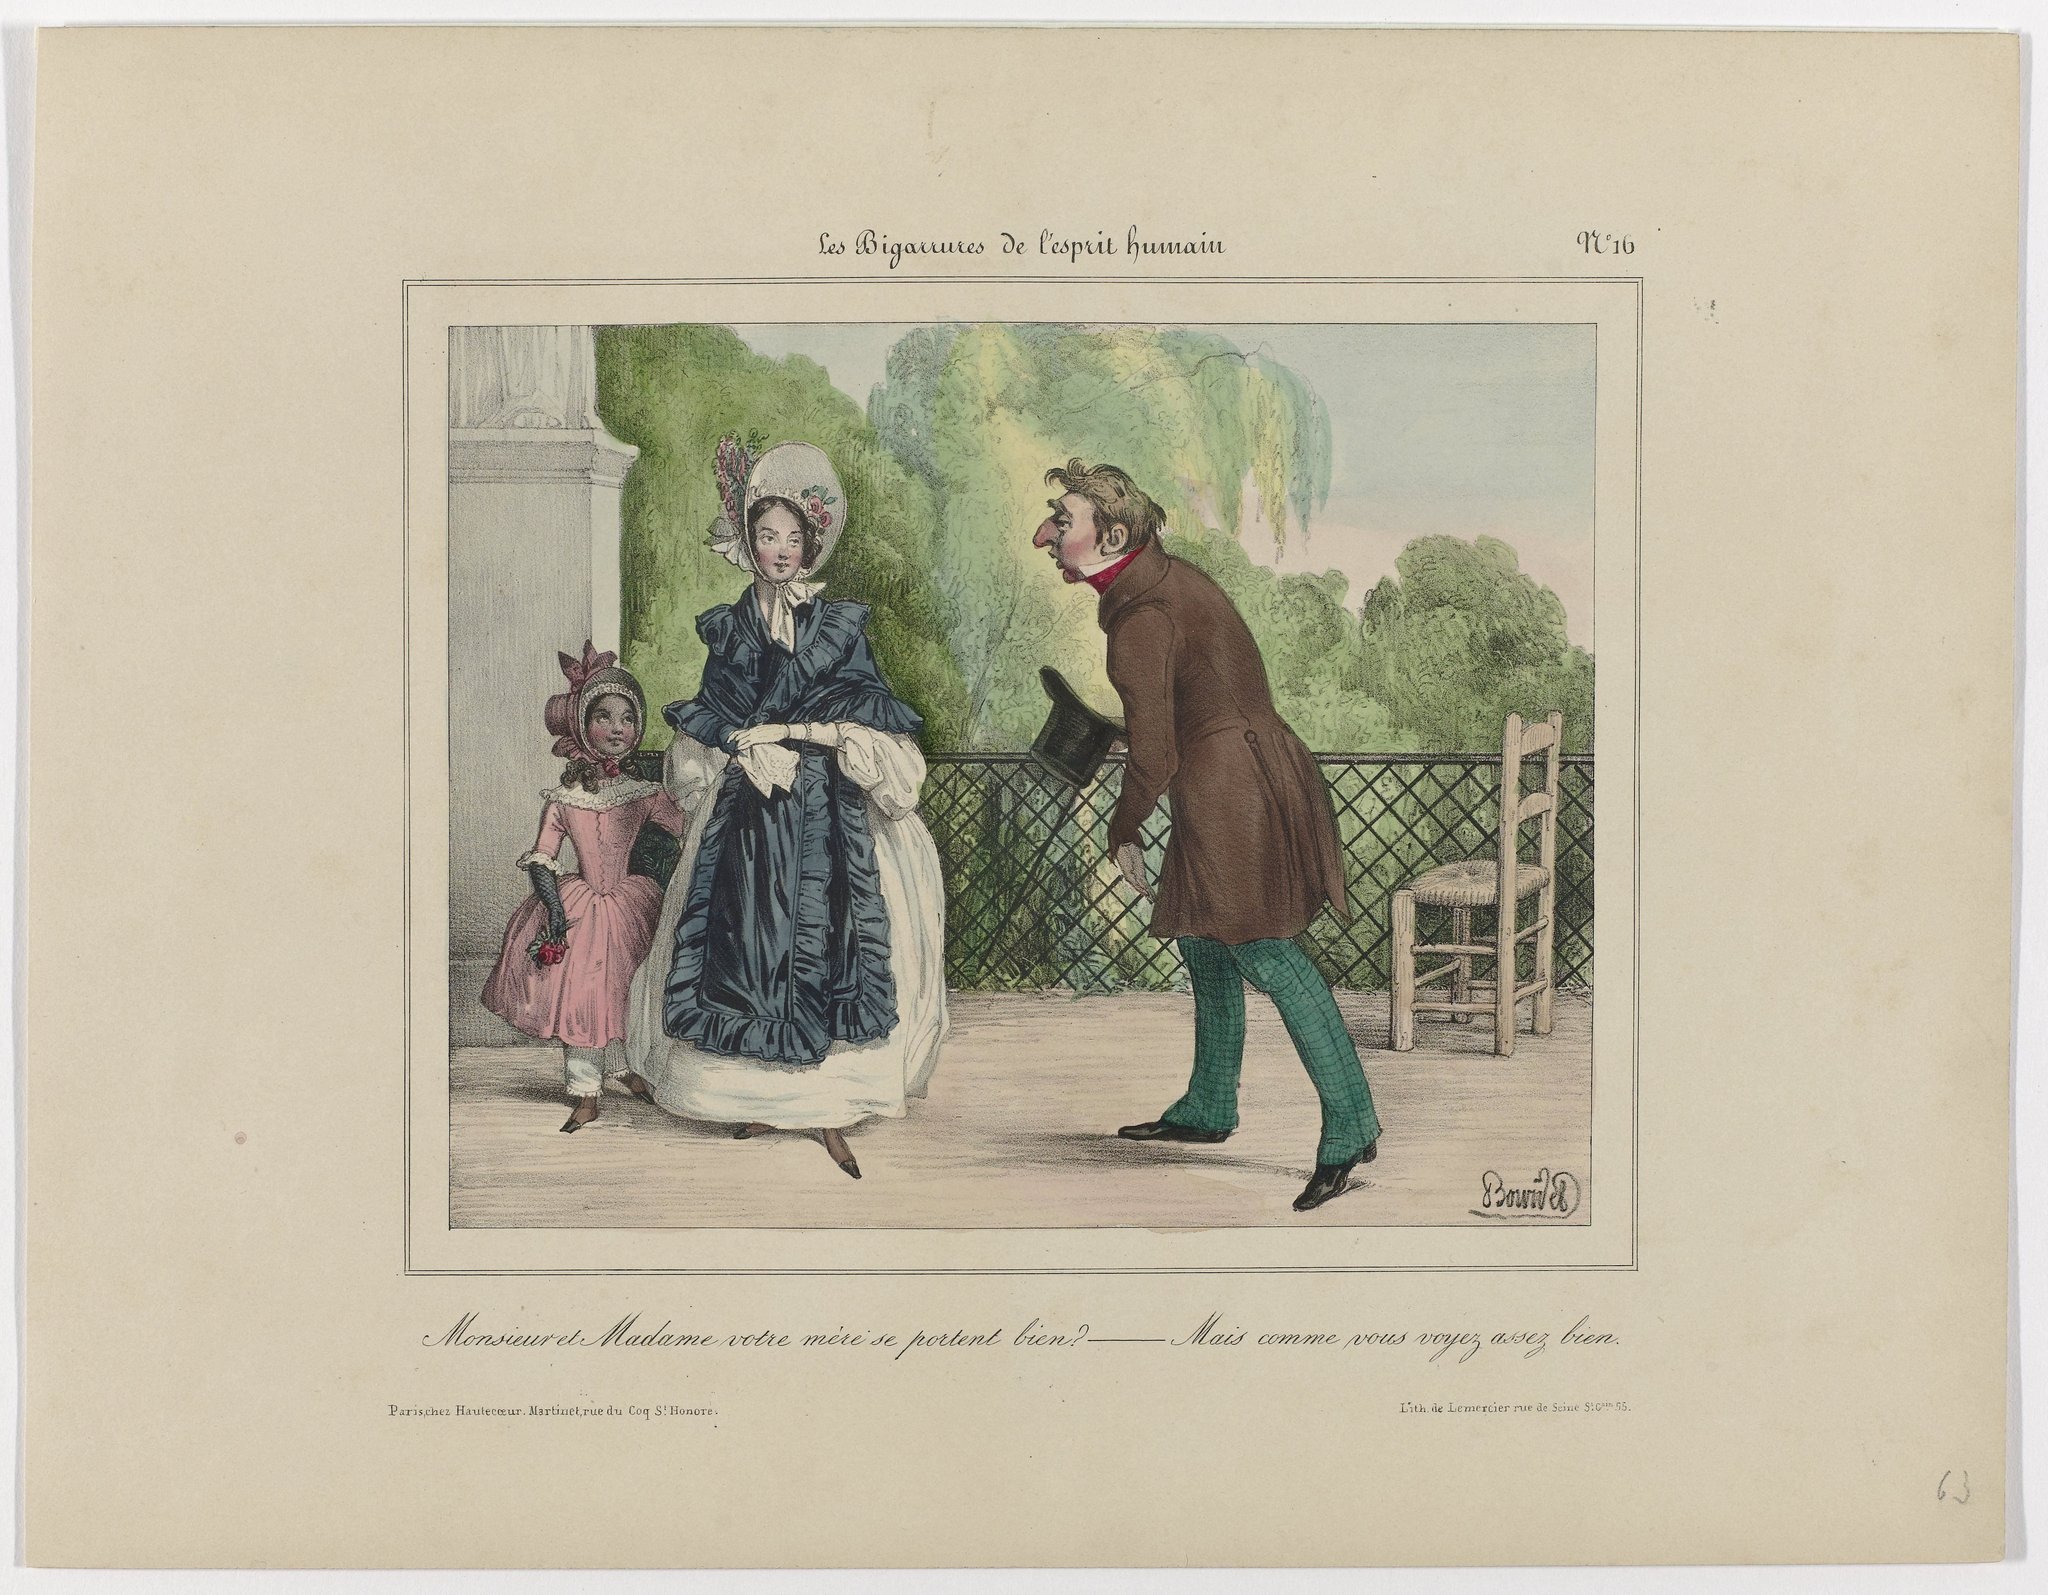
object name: caricature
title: Les Bigarrures de l 'esprit humain, ca. 1830-1831, No. 16 : Monsieur et Madam (...)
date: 1830-1831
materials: paper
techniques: hand coloring, lithograph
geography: paris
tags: head-gear (capote) (+ women's clothes), clothes, costume (+ girls' clothes), underclothes for the lower part of the body: bloomers (+ girls' clothes), baring the head, lifting one's hat, fashion plates, clothes, costume (+ women's clothes), clothes, costume (+ men's clothes)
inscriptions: caption: ‘Monsieur et Madame votre mère se portent bien? - Mais comme vous voyez assez bien.’, title: ‘Les Bigarrures de l'esprit humain’